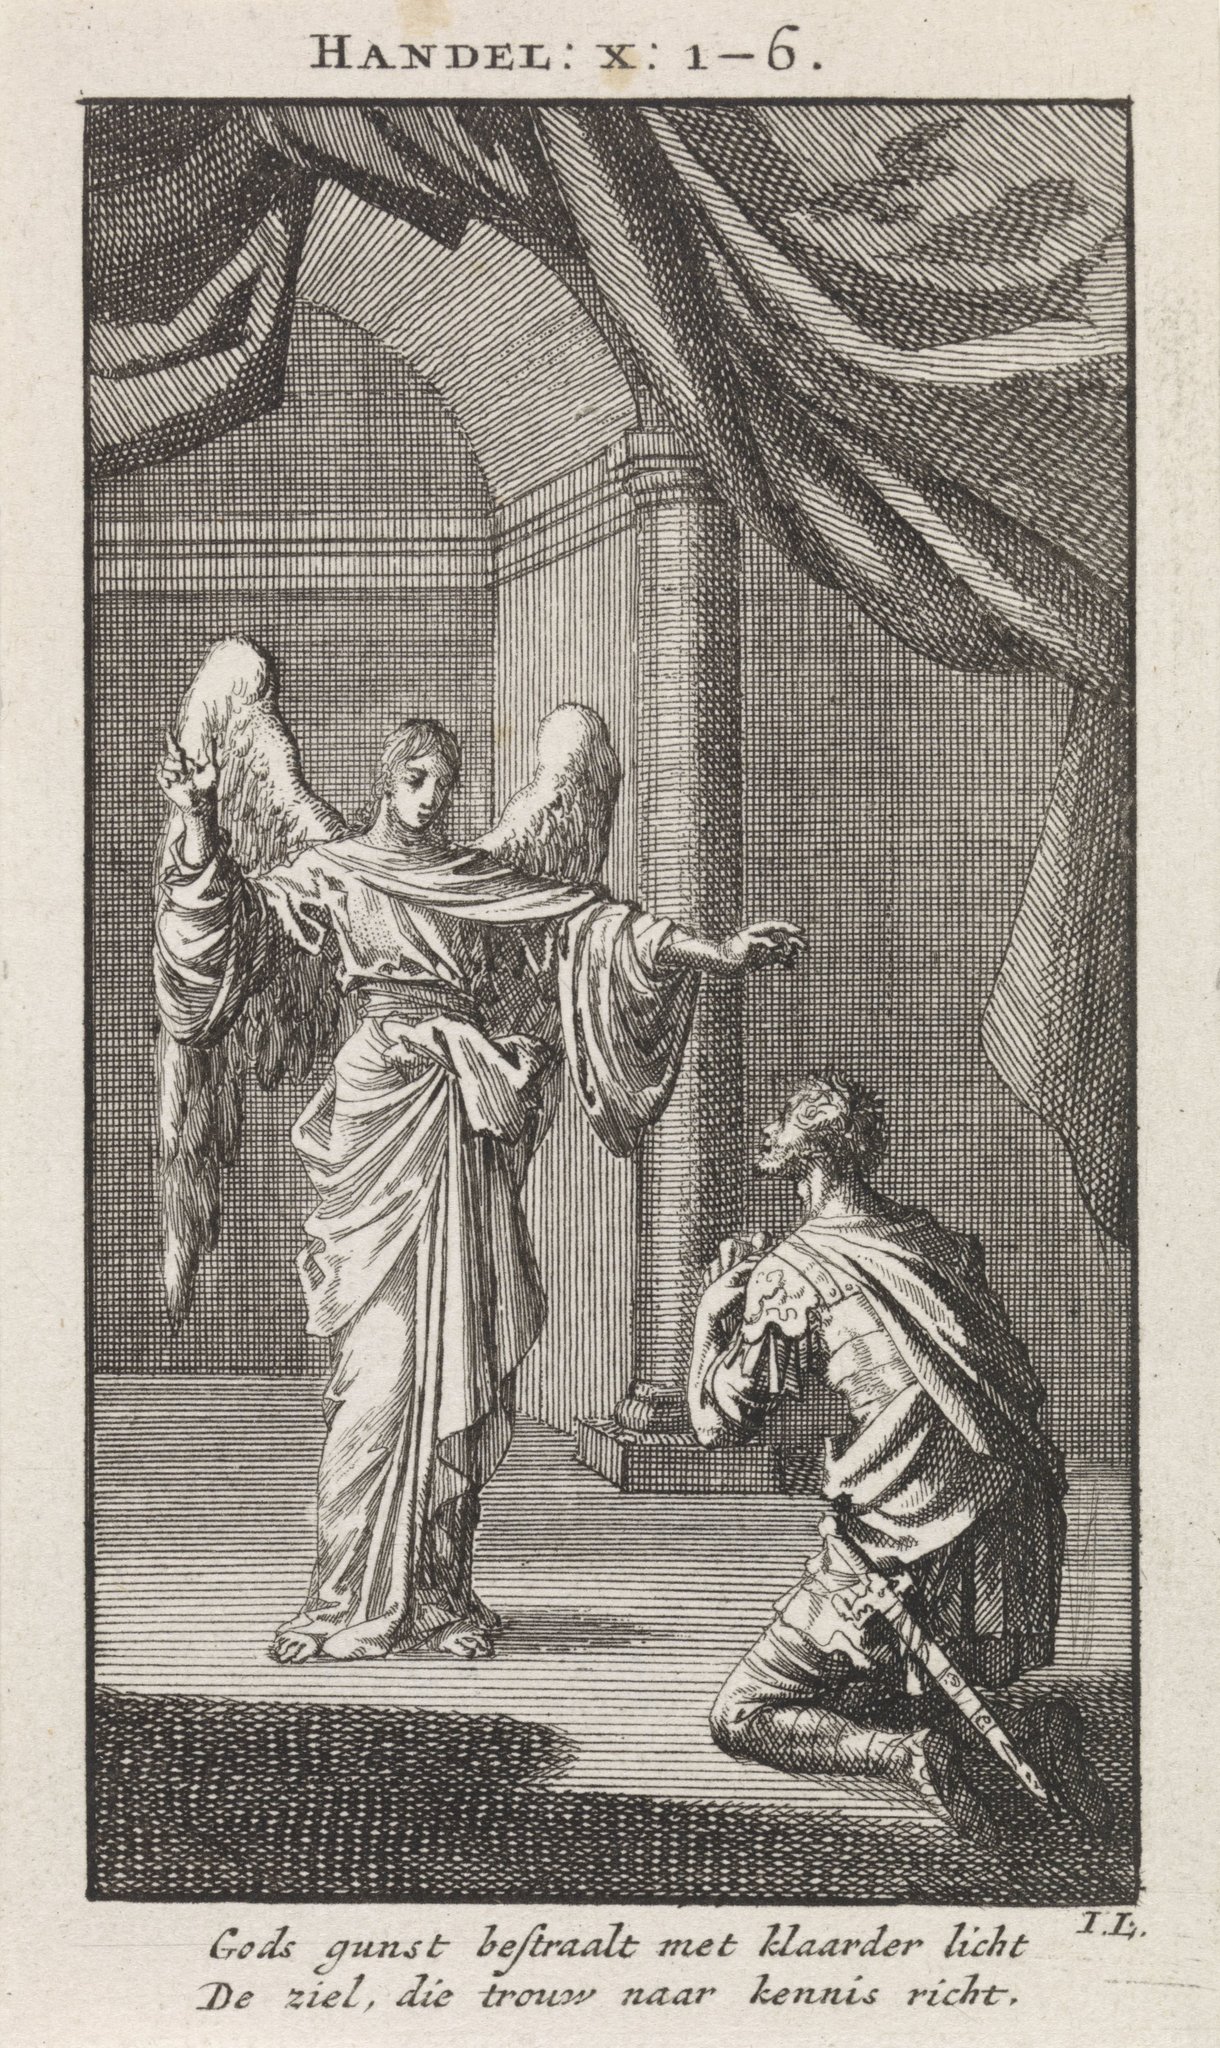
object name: book illustration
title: Cornelius knielt voor de tot hem gezonden engel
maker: jan luyken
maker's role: draughtsman, print maker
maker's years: 1649-1712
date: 1712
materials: paper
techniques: etching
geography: amsterdam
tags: cornelius the centurion and the angel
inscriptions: collector's mark: Lugt 2228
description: Illustratie voor: Luyken, Jan. Bybel printen. Amsterdam: Pieter Arentsz. II (wed.) en Cornelis van der Sys, 1712, p. 39.